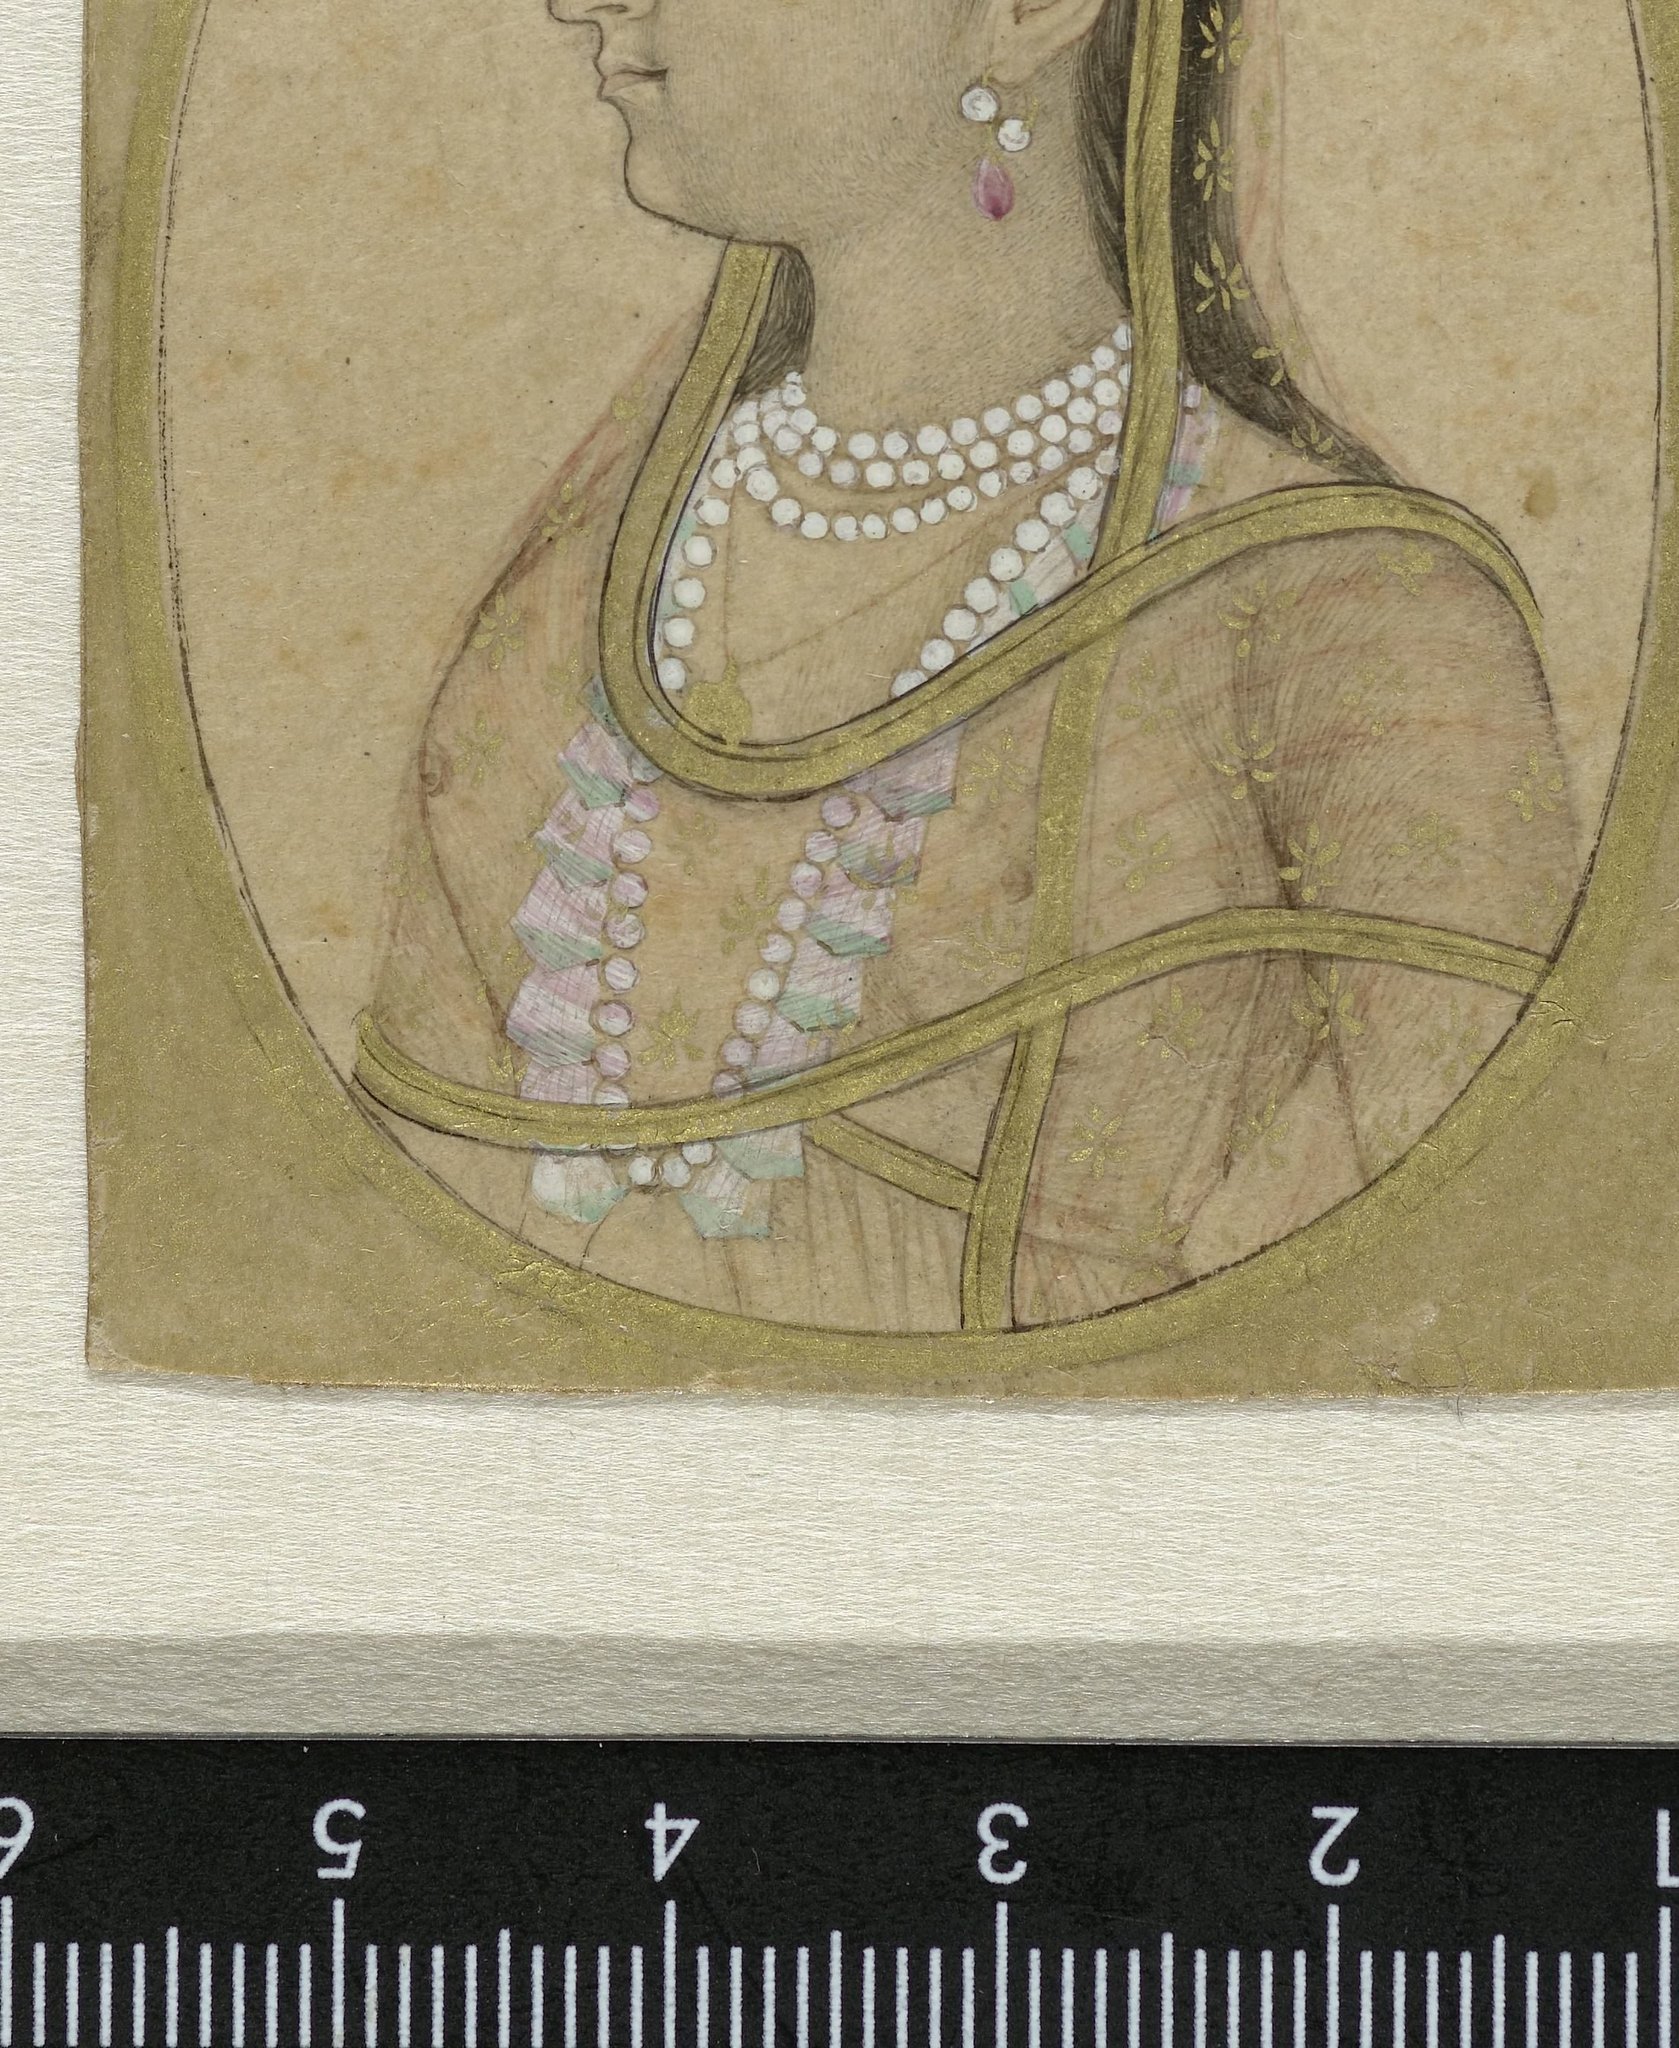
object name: indian miniature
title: Damesportret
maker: Anonymous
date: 1730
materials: paper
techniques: brush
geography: deccan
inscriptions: inscription: ‘.’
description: Een miniatuurportret van een dame met profiel naar links, in een ovaal, met een goudkleurige rand op beige papier. Het ovale portret is opgeplakt op een roze beschilderd vierkantje met een motief van bladerranken in goud en het geheel is op een rechthoekig stuk karton geplakt met een zwarte kaderlijn om de sierpapiertjes.